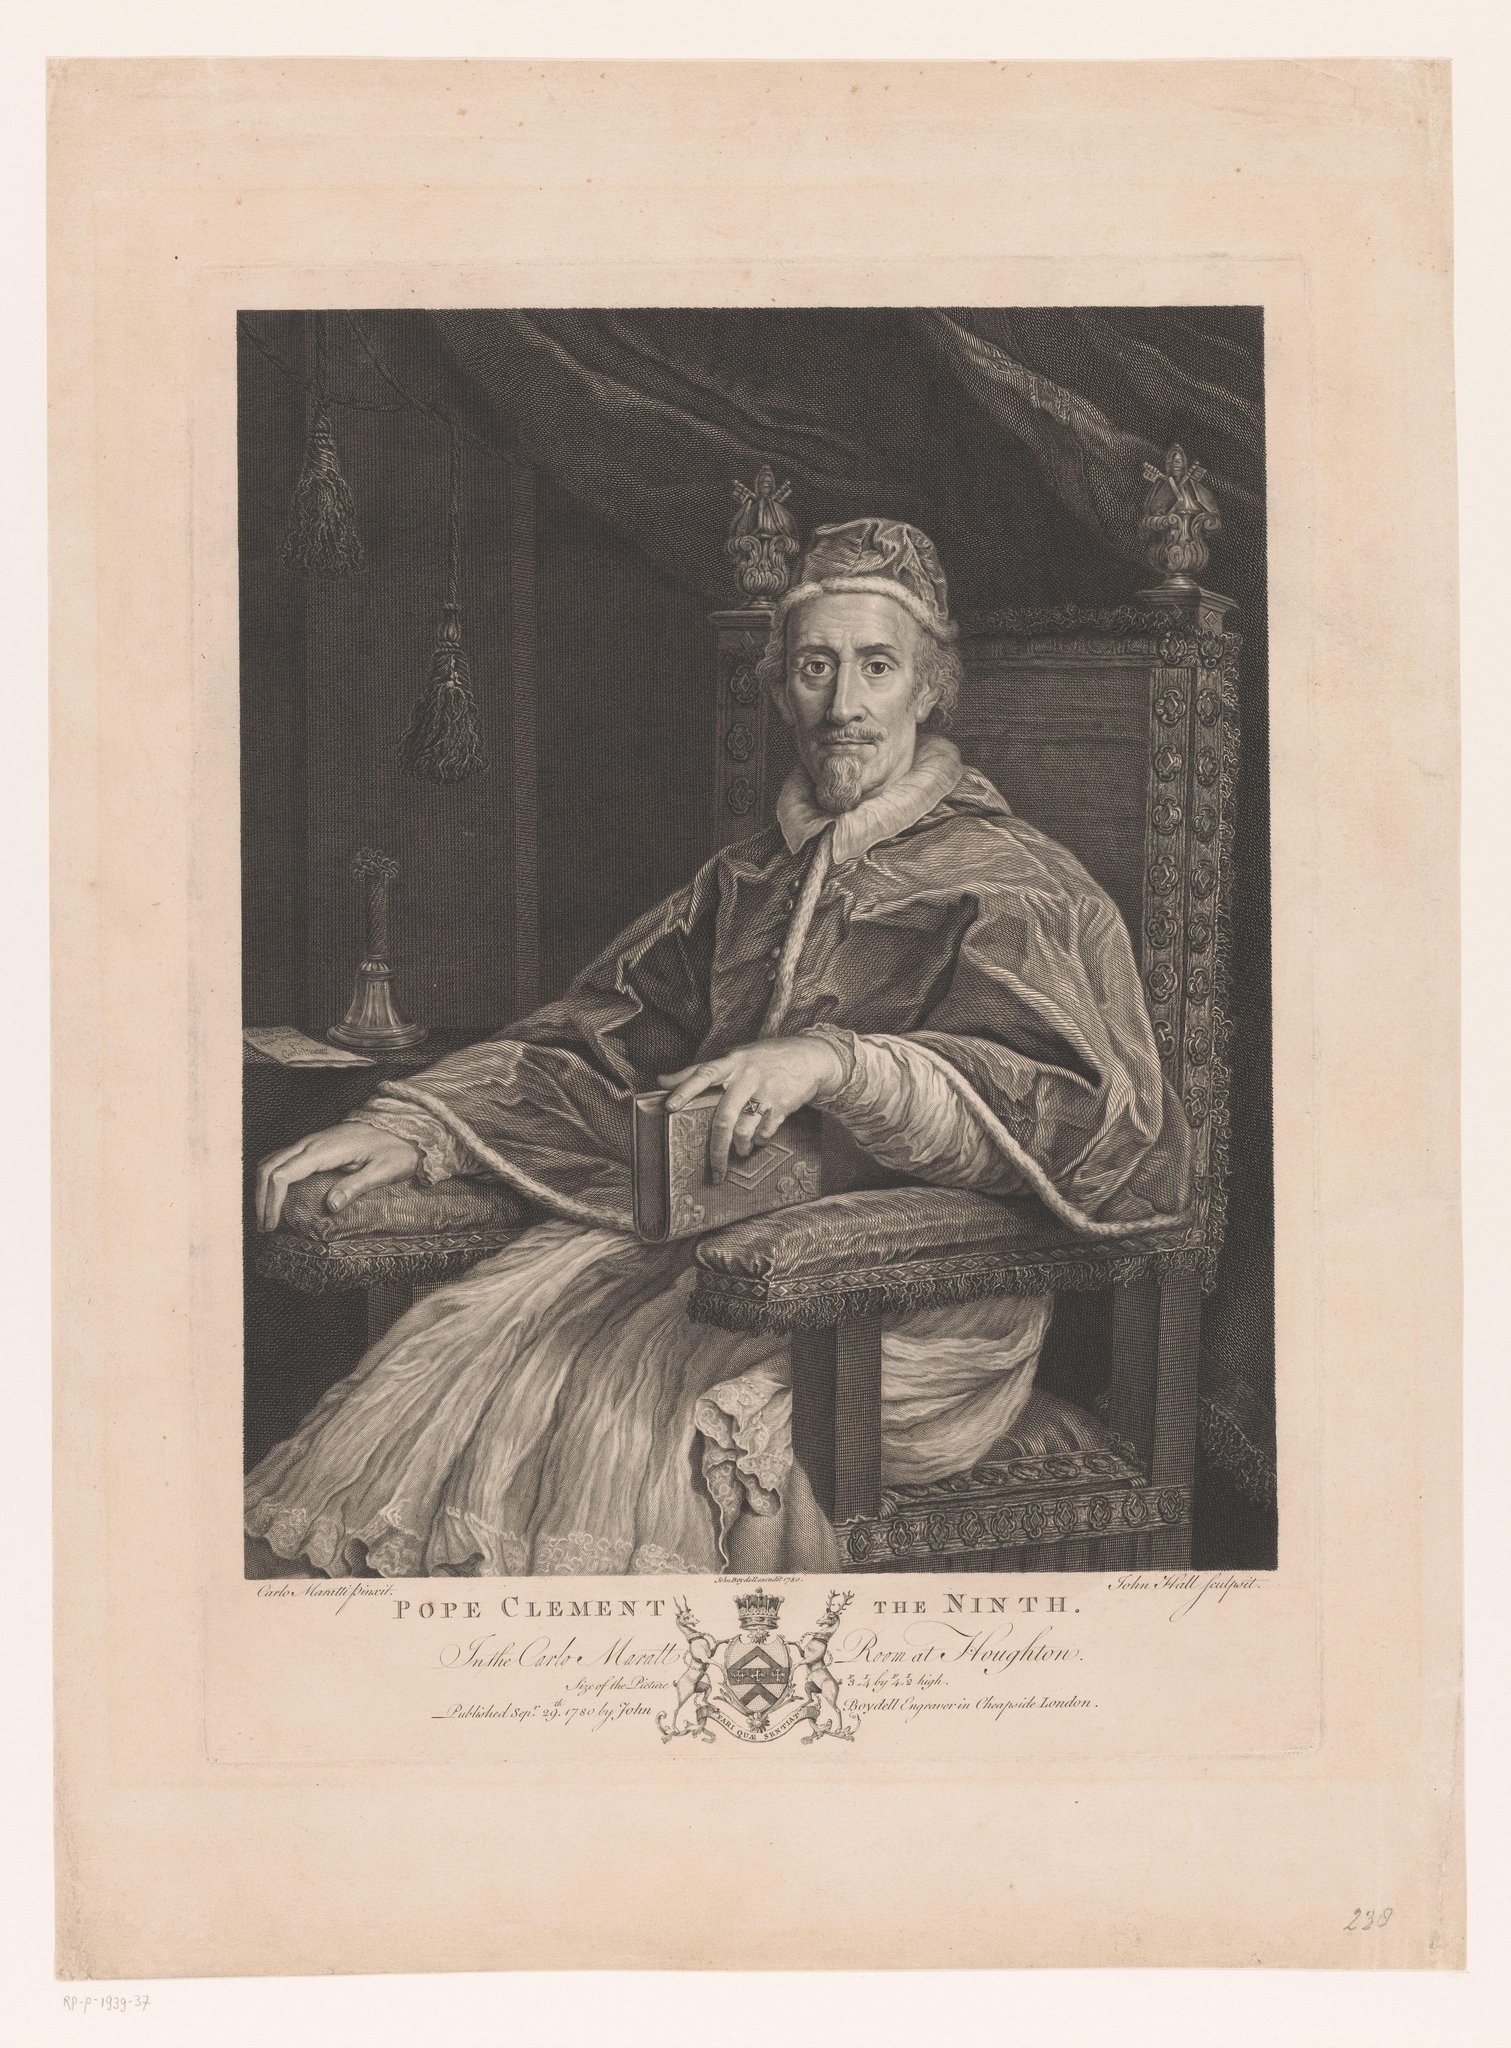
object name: print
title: Portret van paus Clemens IX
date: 1780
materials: paper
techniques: engraving, etching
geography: london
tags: clemens ix, historical persons, pope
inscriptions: collector's mark: Lugt 2228